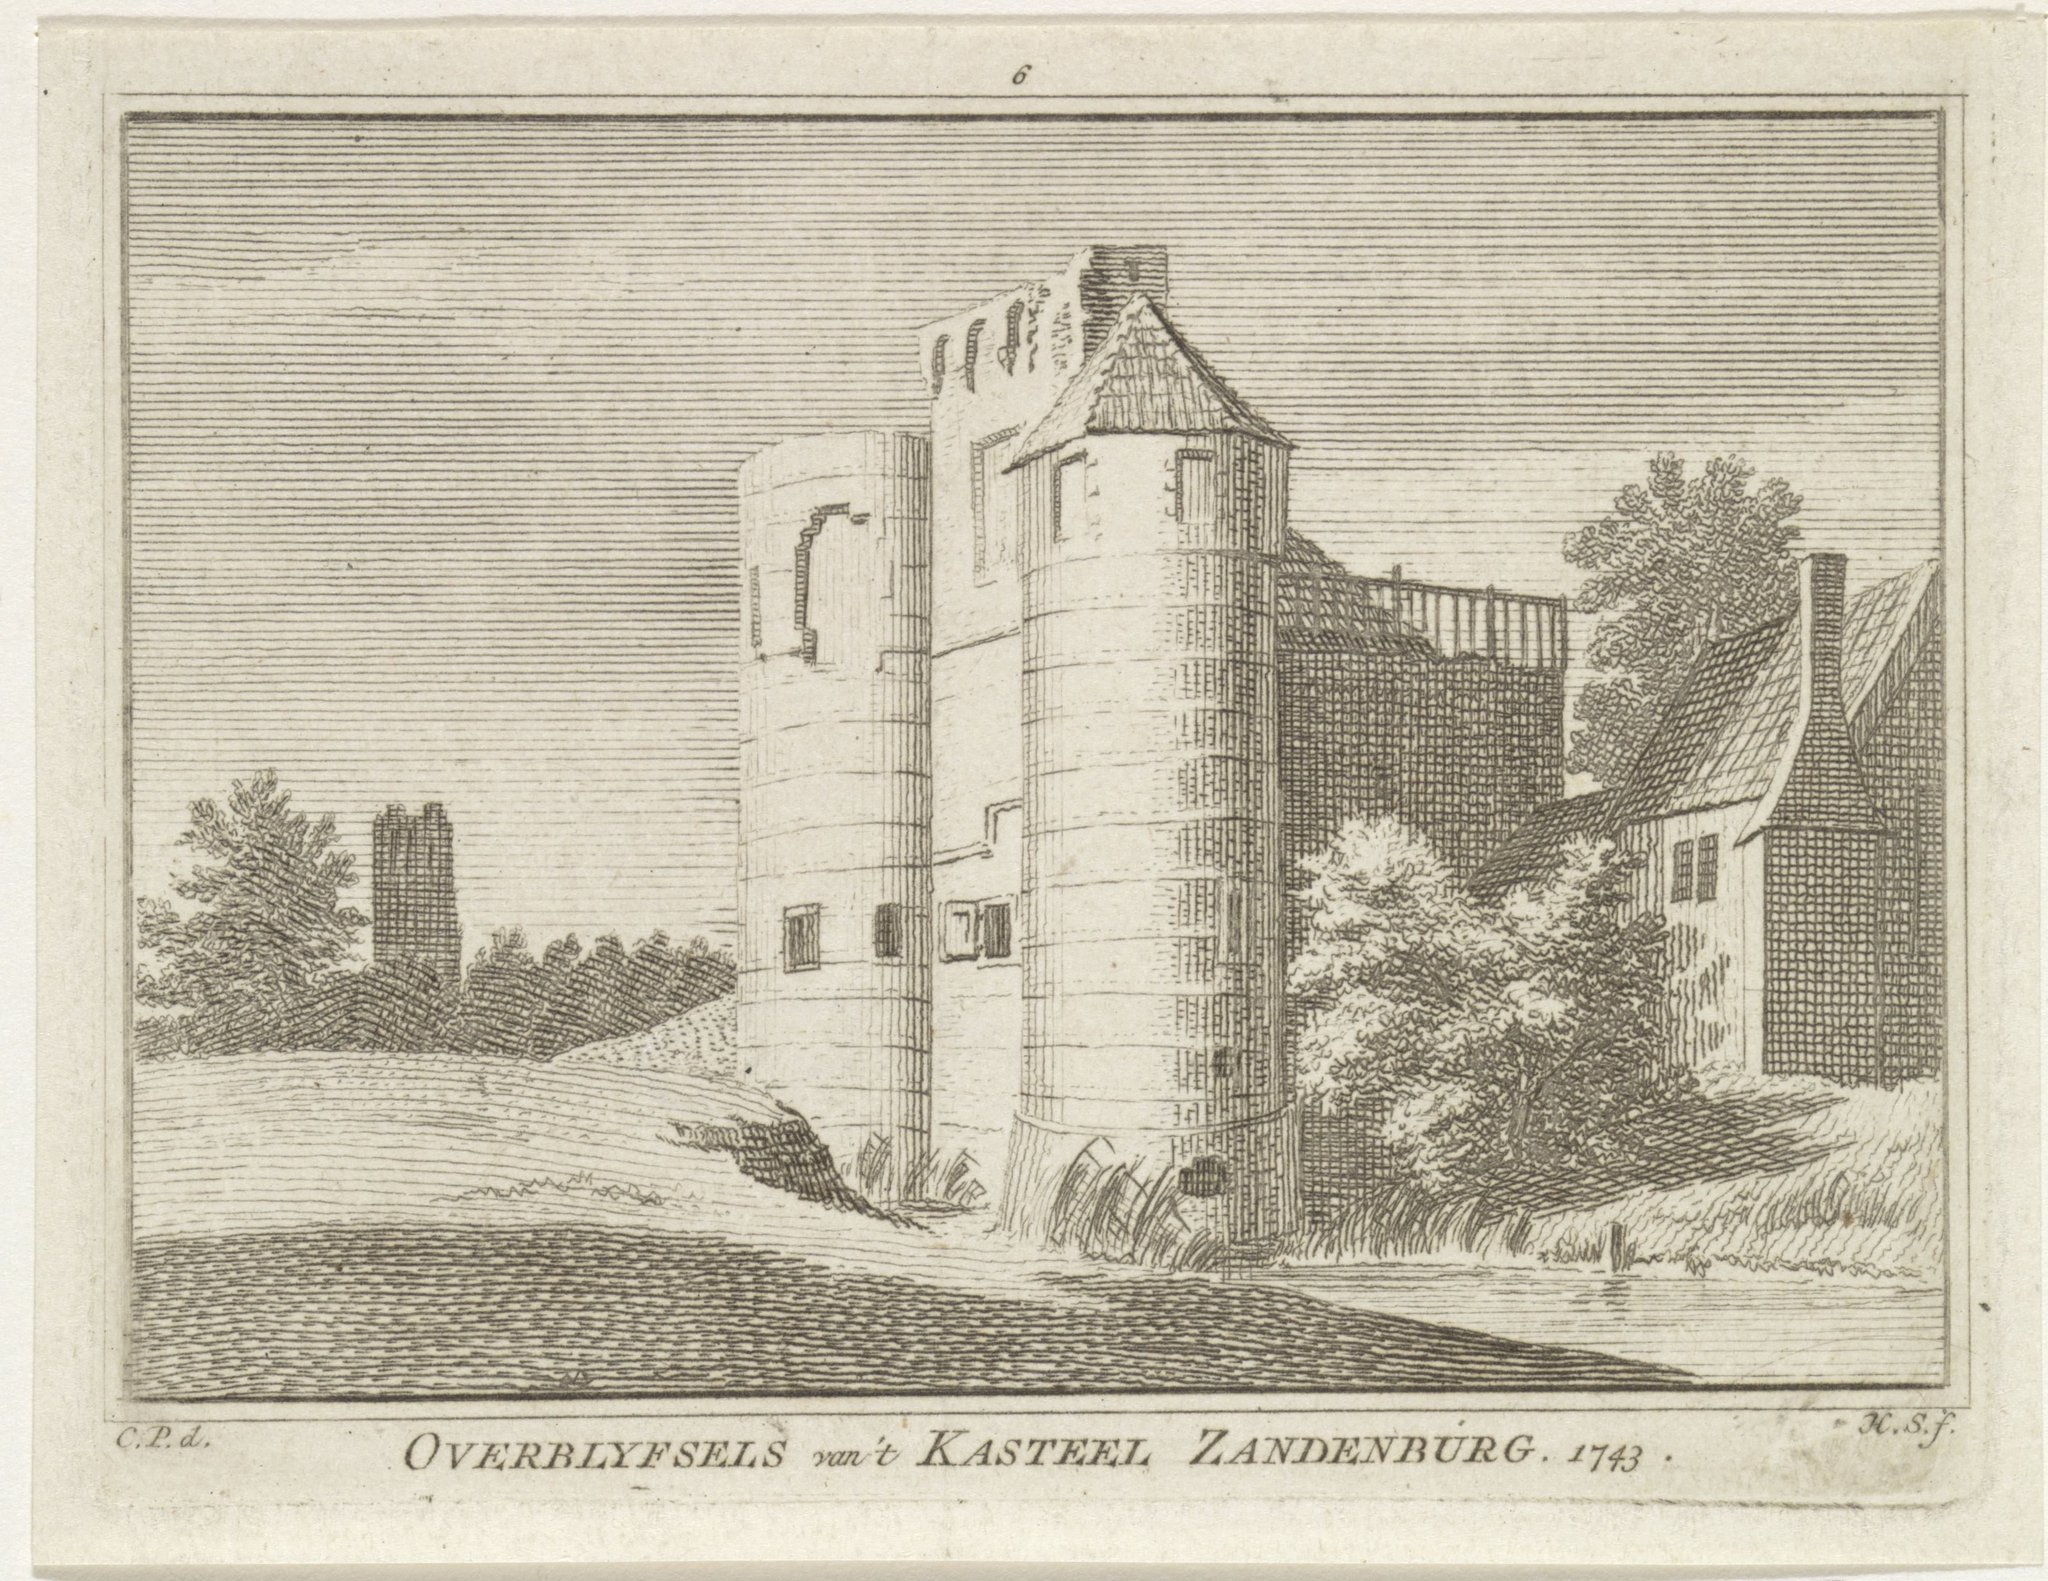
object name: book illustration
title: Overblyfsels van 't kasteel Zandenburg, 1743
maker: hendrik spilman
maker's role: draughtsman, painter, print maker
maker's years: 1721-1784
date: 1754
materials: paper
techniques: etching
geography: haarlem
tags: ruin of a dwelling, house, castle, etc.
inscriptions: collector's mark: Lugt 2228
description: Prent gebruikt in: Het verheerlykt Nederland of kabinet van hedendaagsche gezigten van steden, dorpen, sloten ... en andere voornaame stad- en landgebouwen, in en omtrent alle de byzondere Vereenigde Nederlandsche Provinciën : gedurende de laatste jaaren door vermaarden kunsttekenaren na het leven getekent en ... in 't koper gebragt ... dienende tot opheldering der beschryvinge van den Tegenwoordigen Staat der Vereenigde Nederlanden. Deel V, 1754. Amsterdam: Isaac Tirion, 1745-1774.